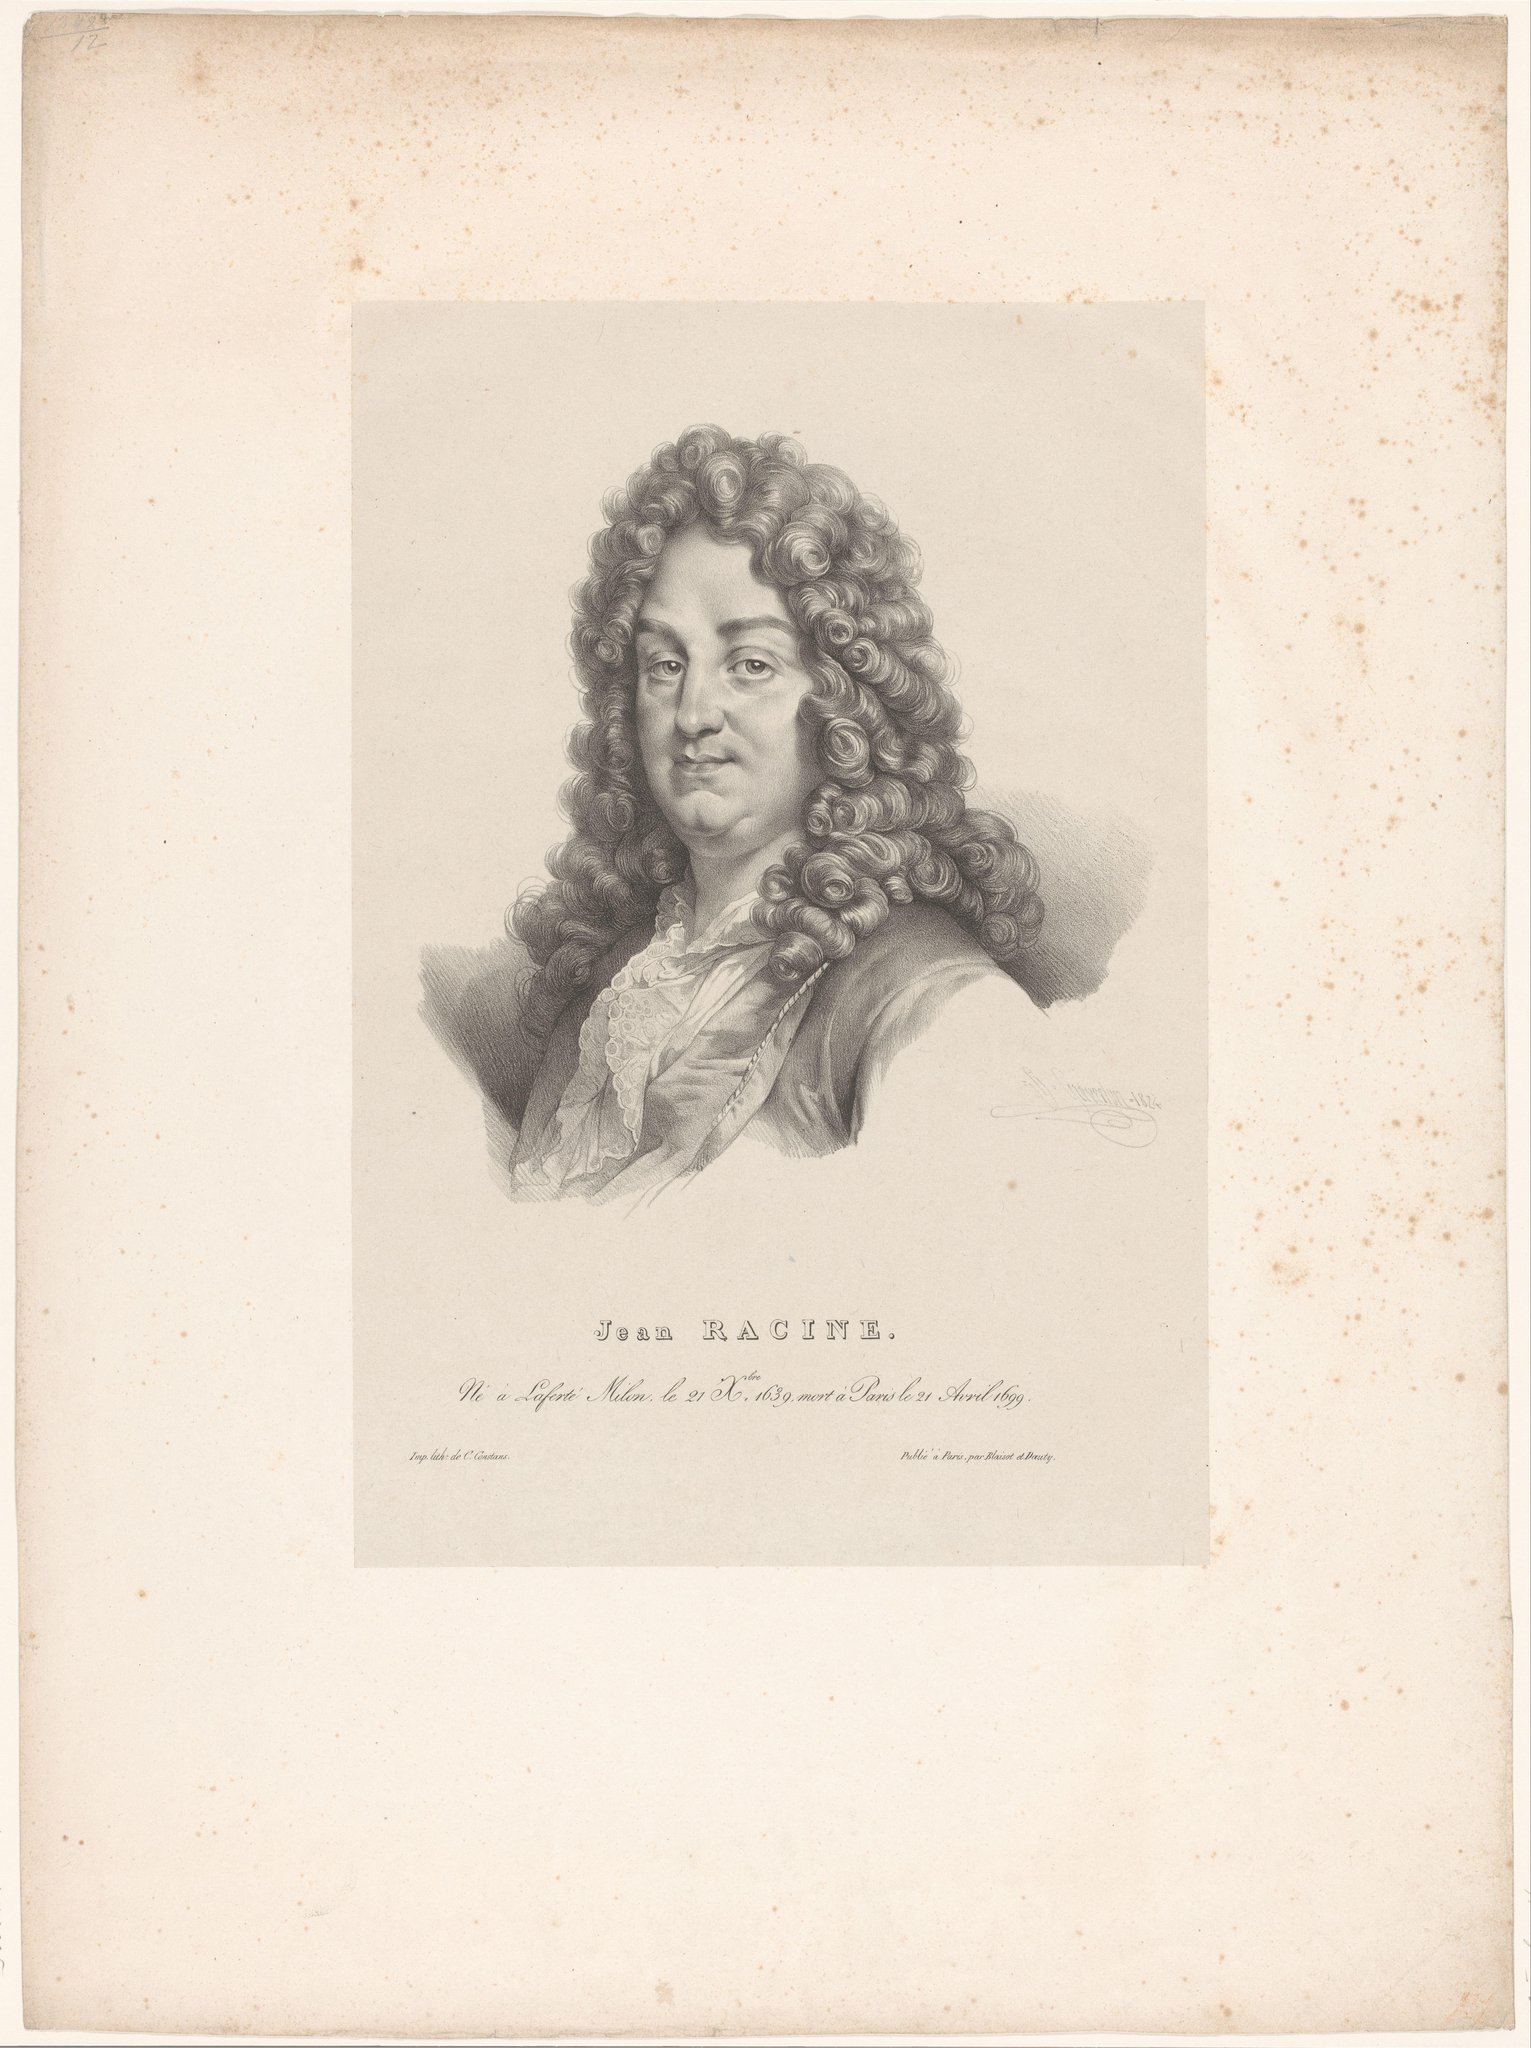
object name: print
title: Jean Racine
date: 1824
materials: paper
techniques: lithograph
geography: paris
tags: france, paris, jean racine, historical persons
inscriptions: collector's mark: Lugt 2228a